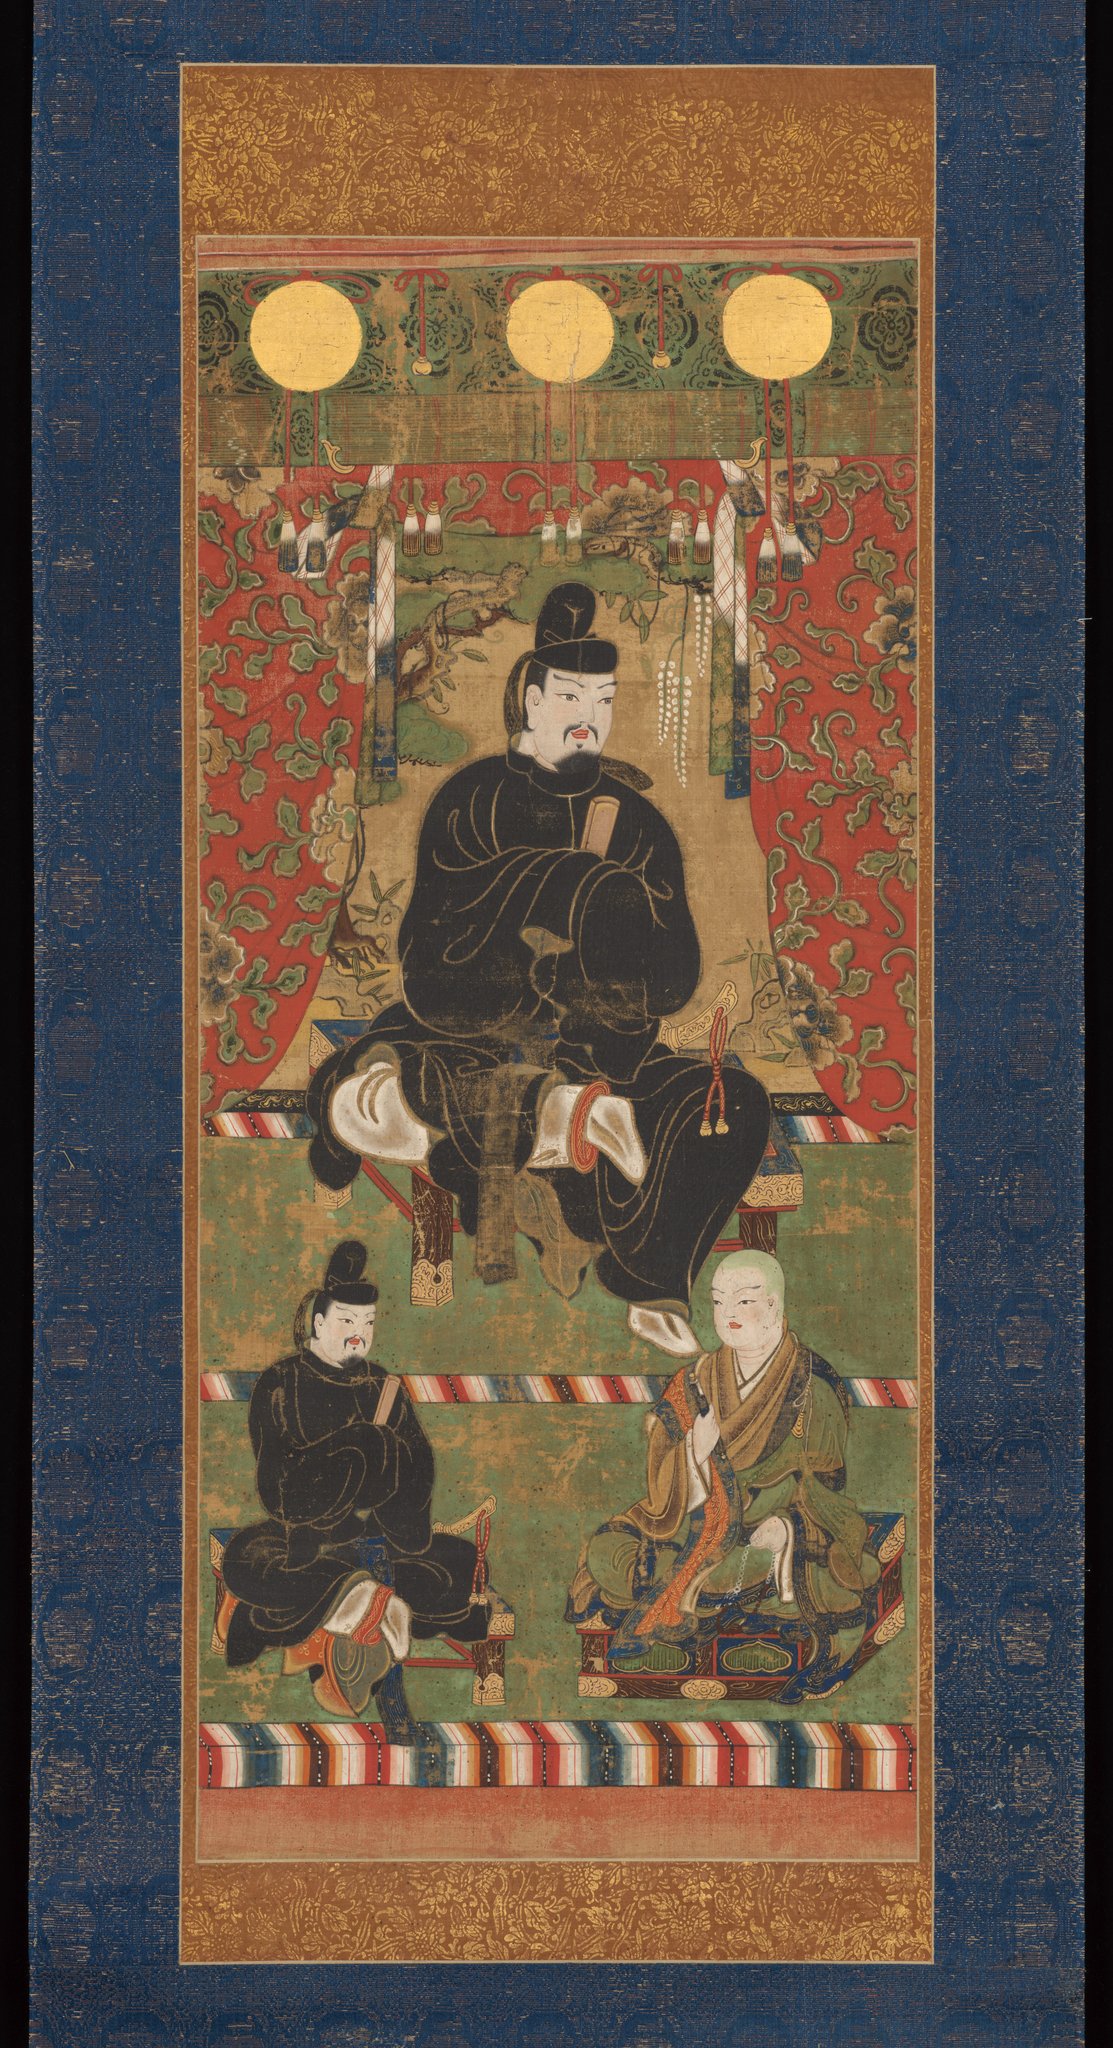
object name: hanging scroll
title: Fujiwara no Kamatari as a Shinto Deity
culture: japanese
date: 1350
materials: silk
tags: men,deities